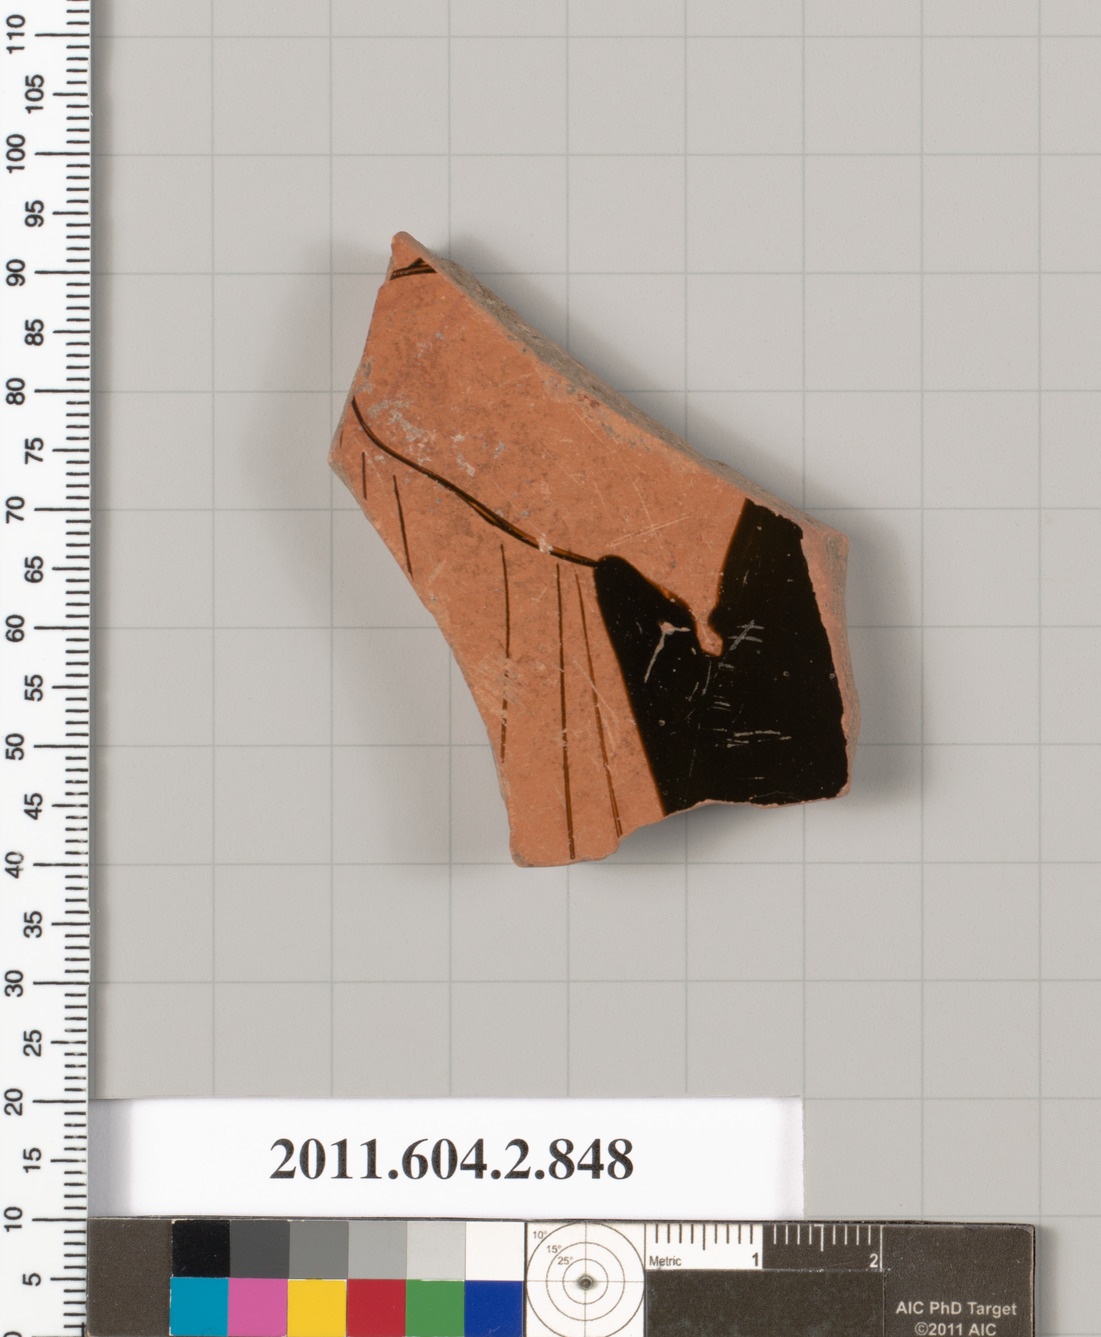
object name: bell krater fragment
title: Terracotta fragment of a bell-krater (bowl for mixing wine and water)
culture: greek, attic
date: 467-435 BCE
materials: terracotta